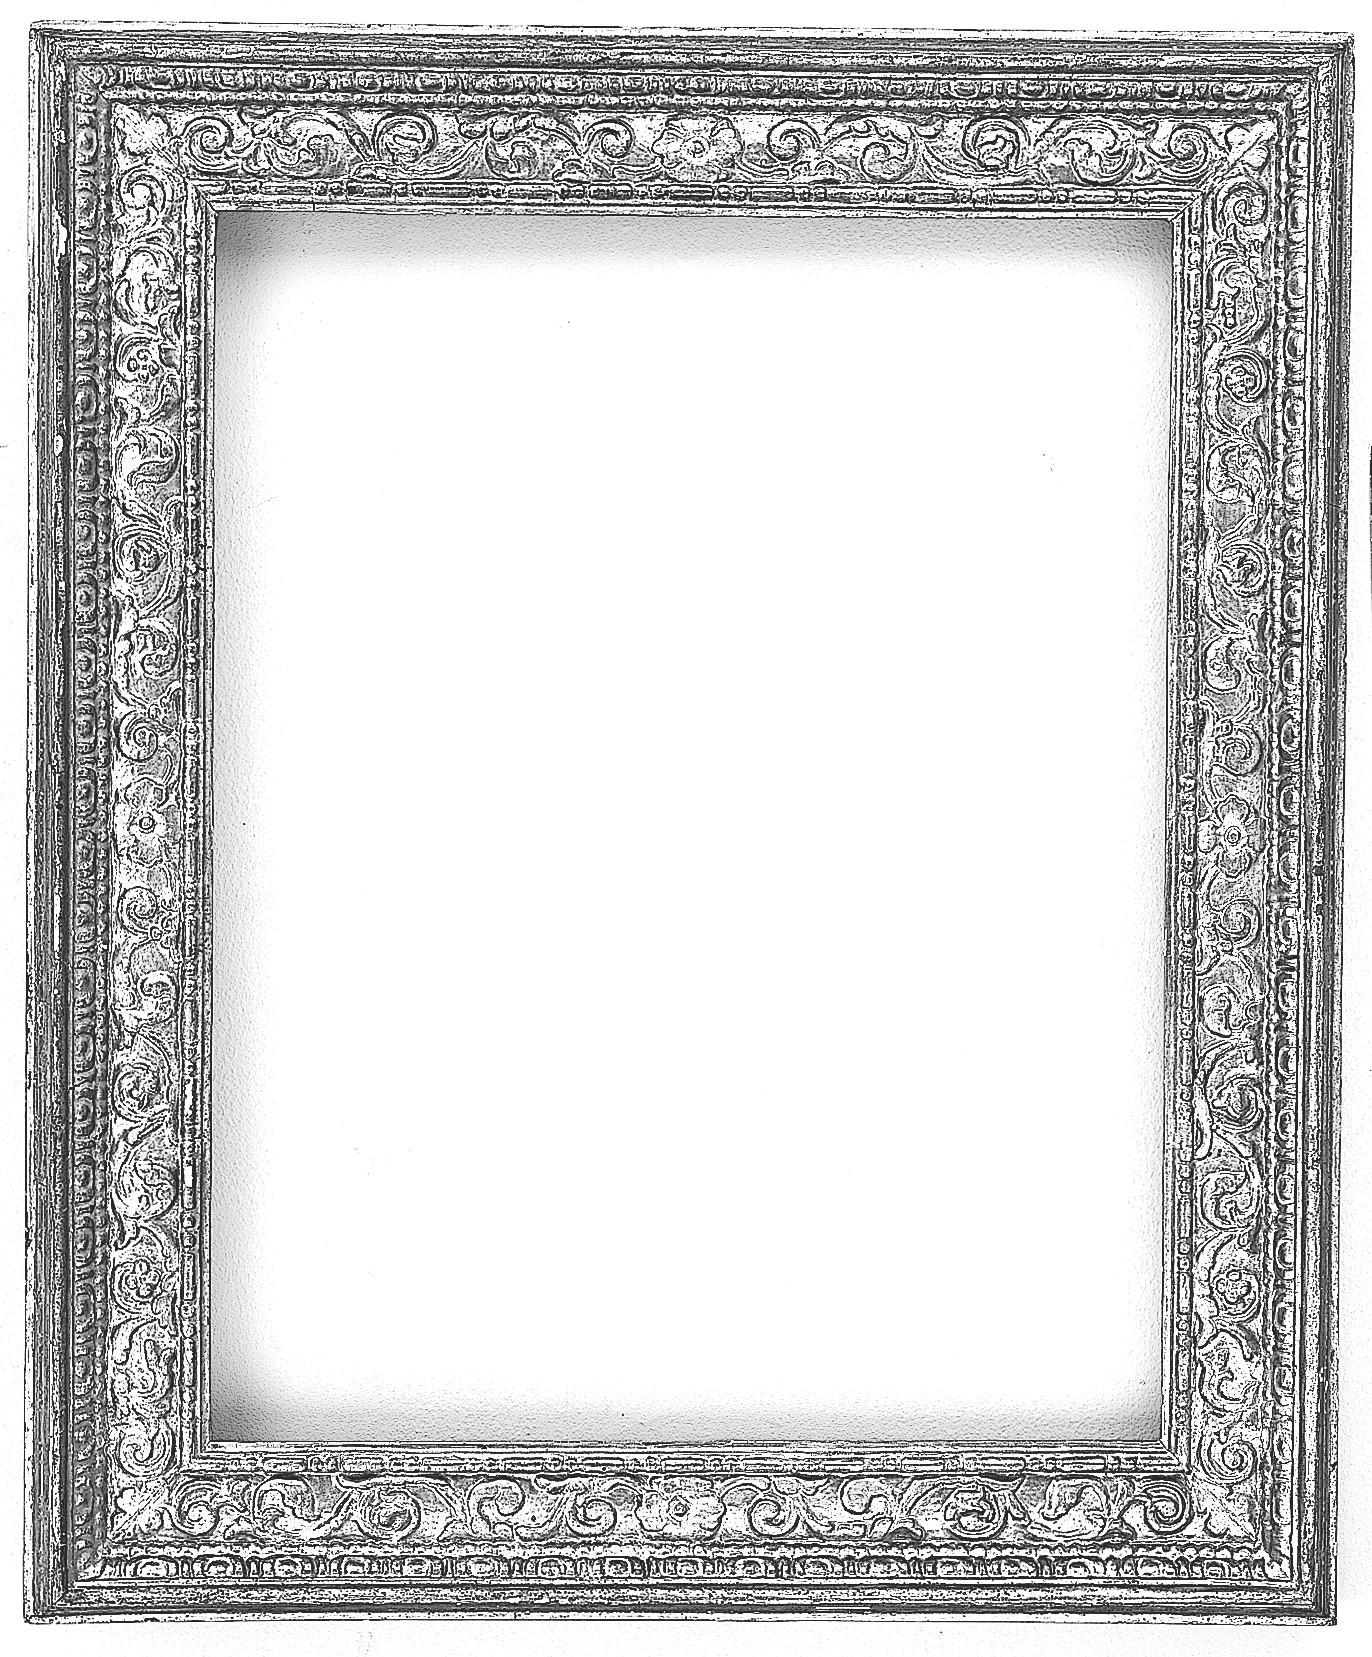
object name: frame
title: Cassetta frame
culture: italian, veneto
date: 1767-1800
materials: wood